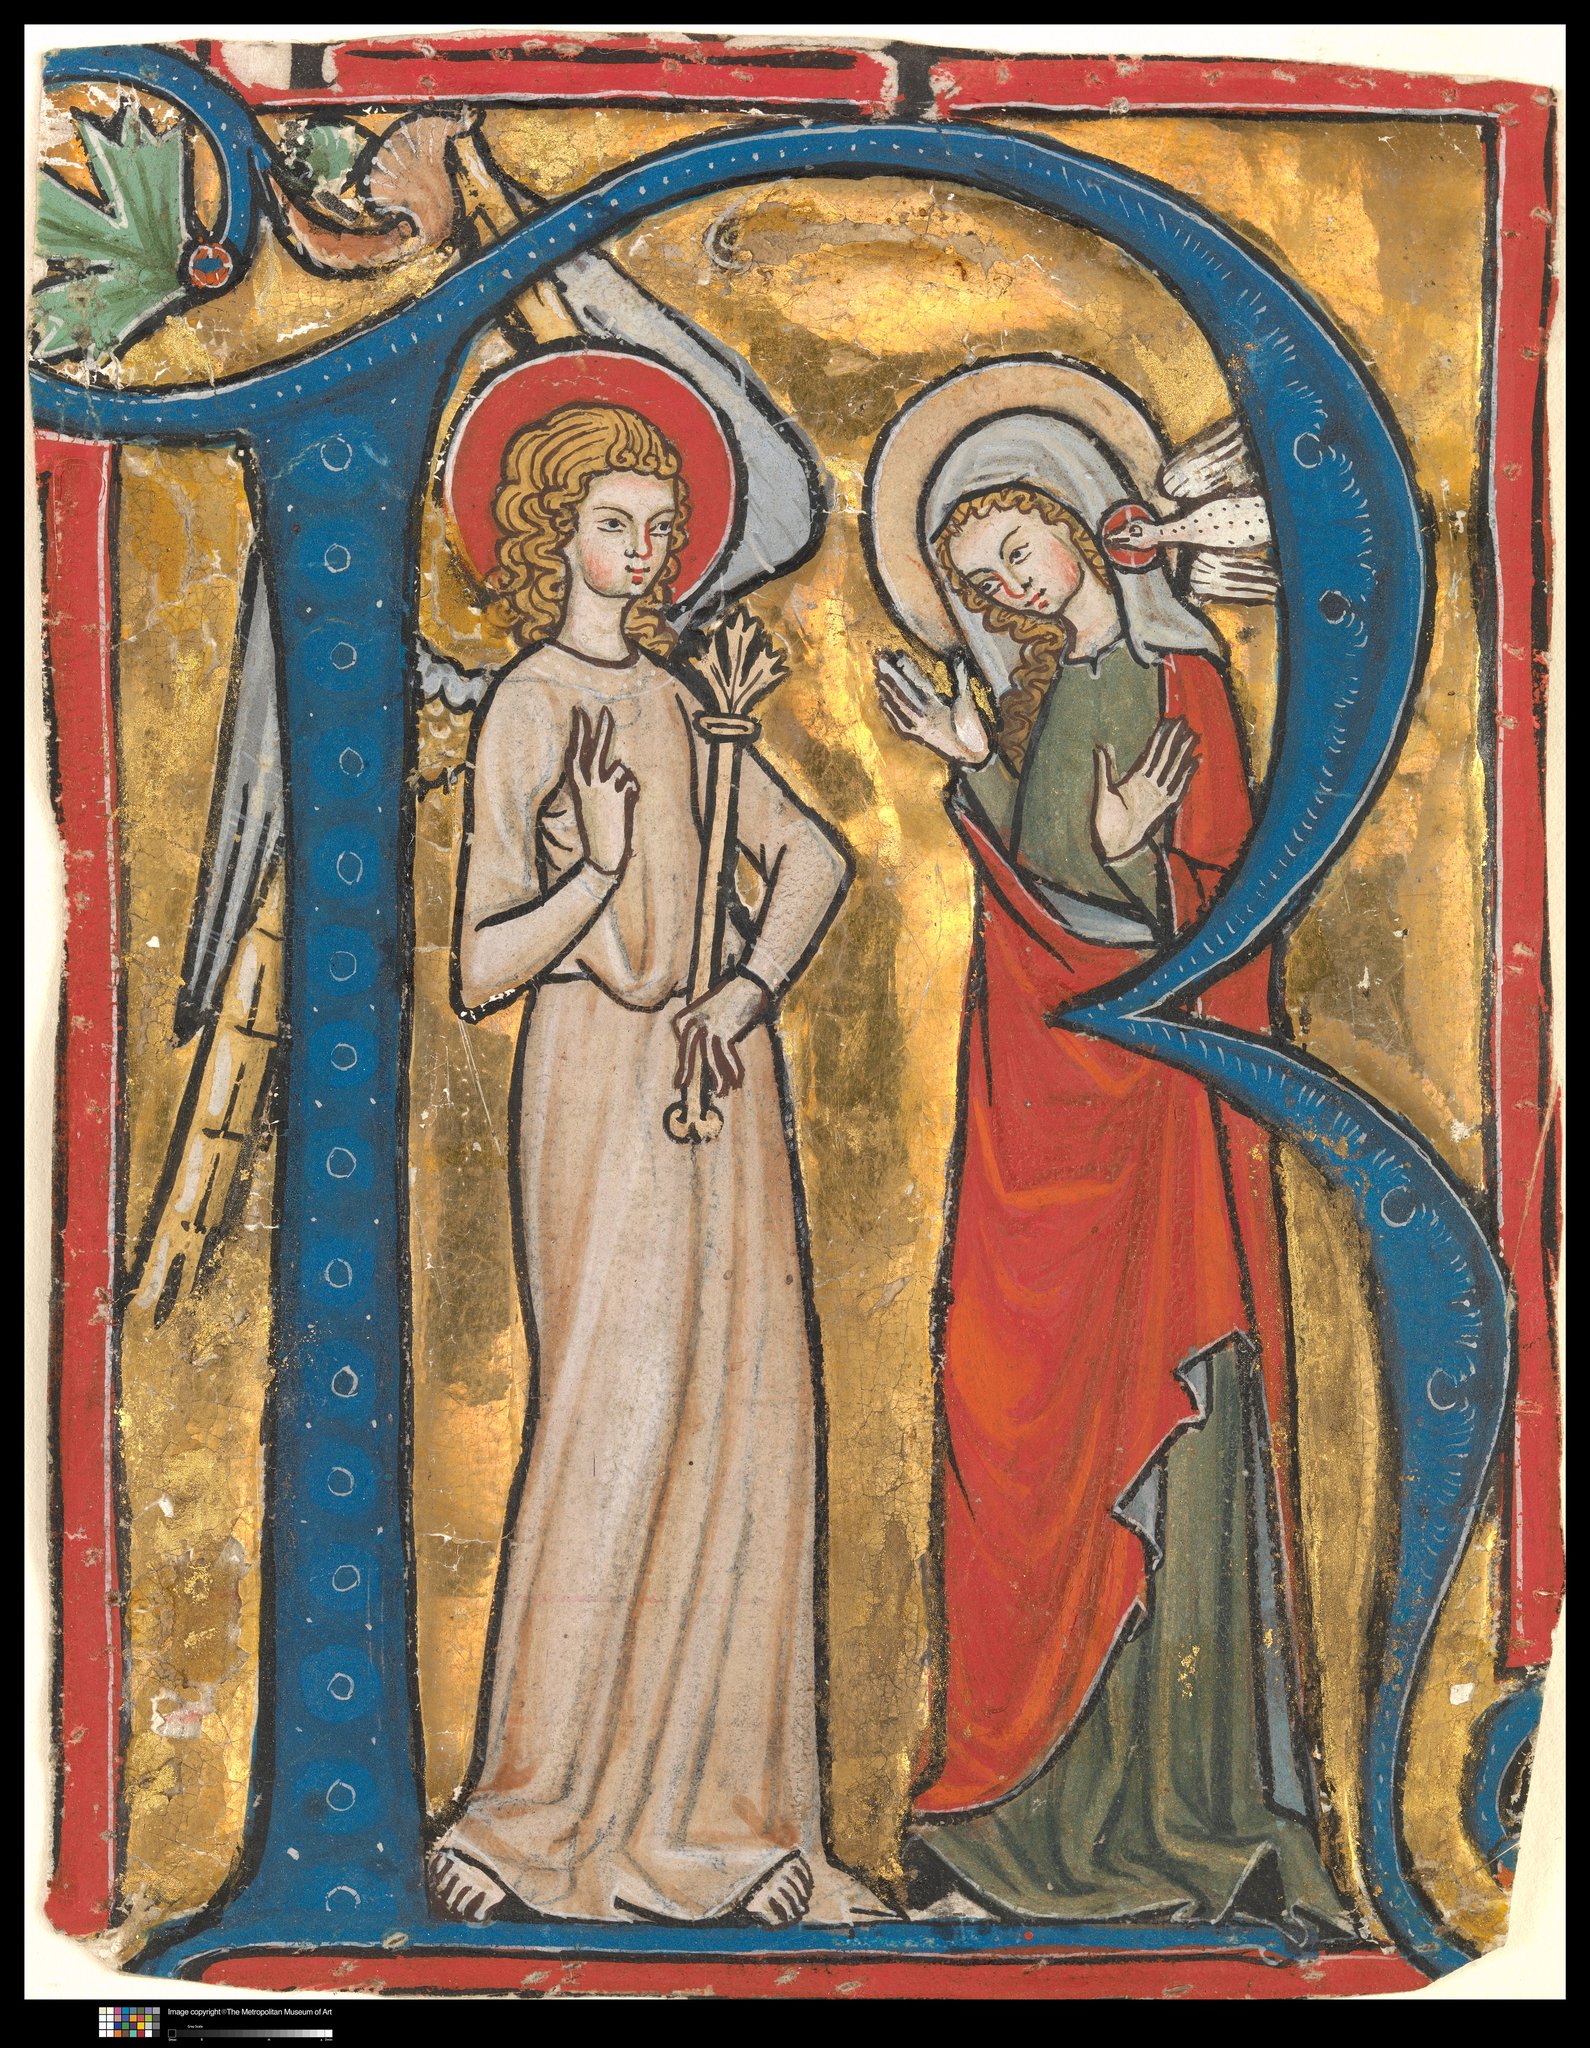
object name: gradual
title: Manuscript Illumination with the Annunciation in an Initial R, from a Gradual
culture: upper rhenish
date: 1300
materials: gold, ink, parchment, paint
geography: switzerland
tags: doves,virgin mary,annunciation